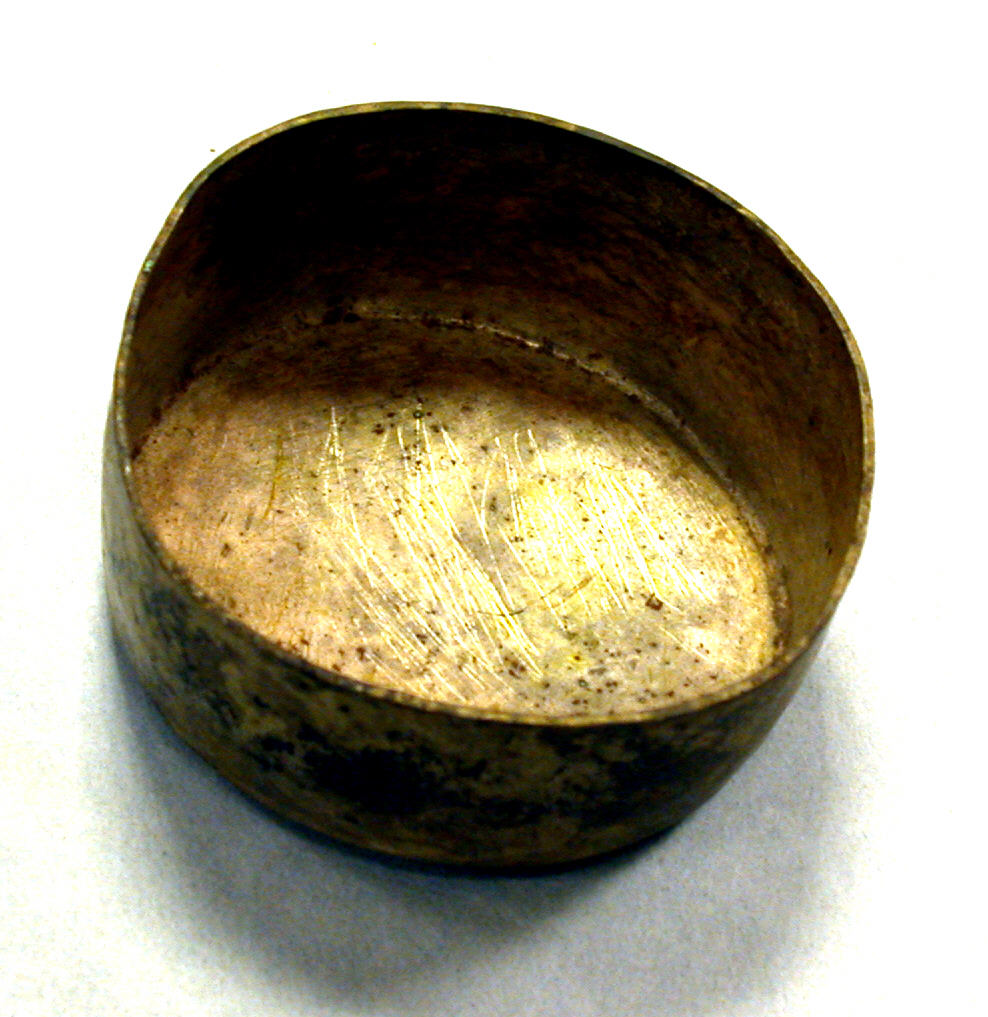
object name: rattle fragment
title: Hammered Silver Rattle Beaker Fragment (?)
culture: peruvian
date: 701-1566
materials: gilt, silver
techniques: hammering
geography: peru